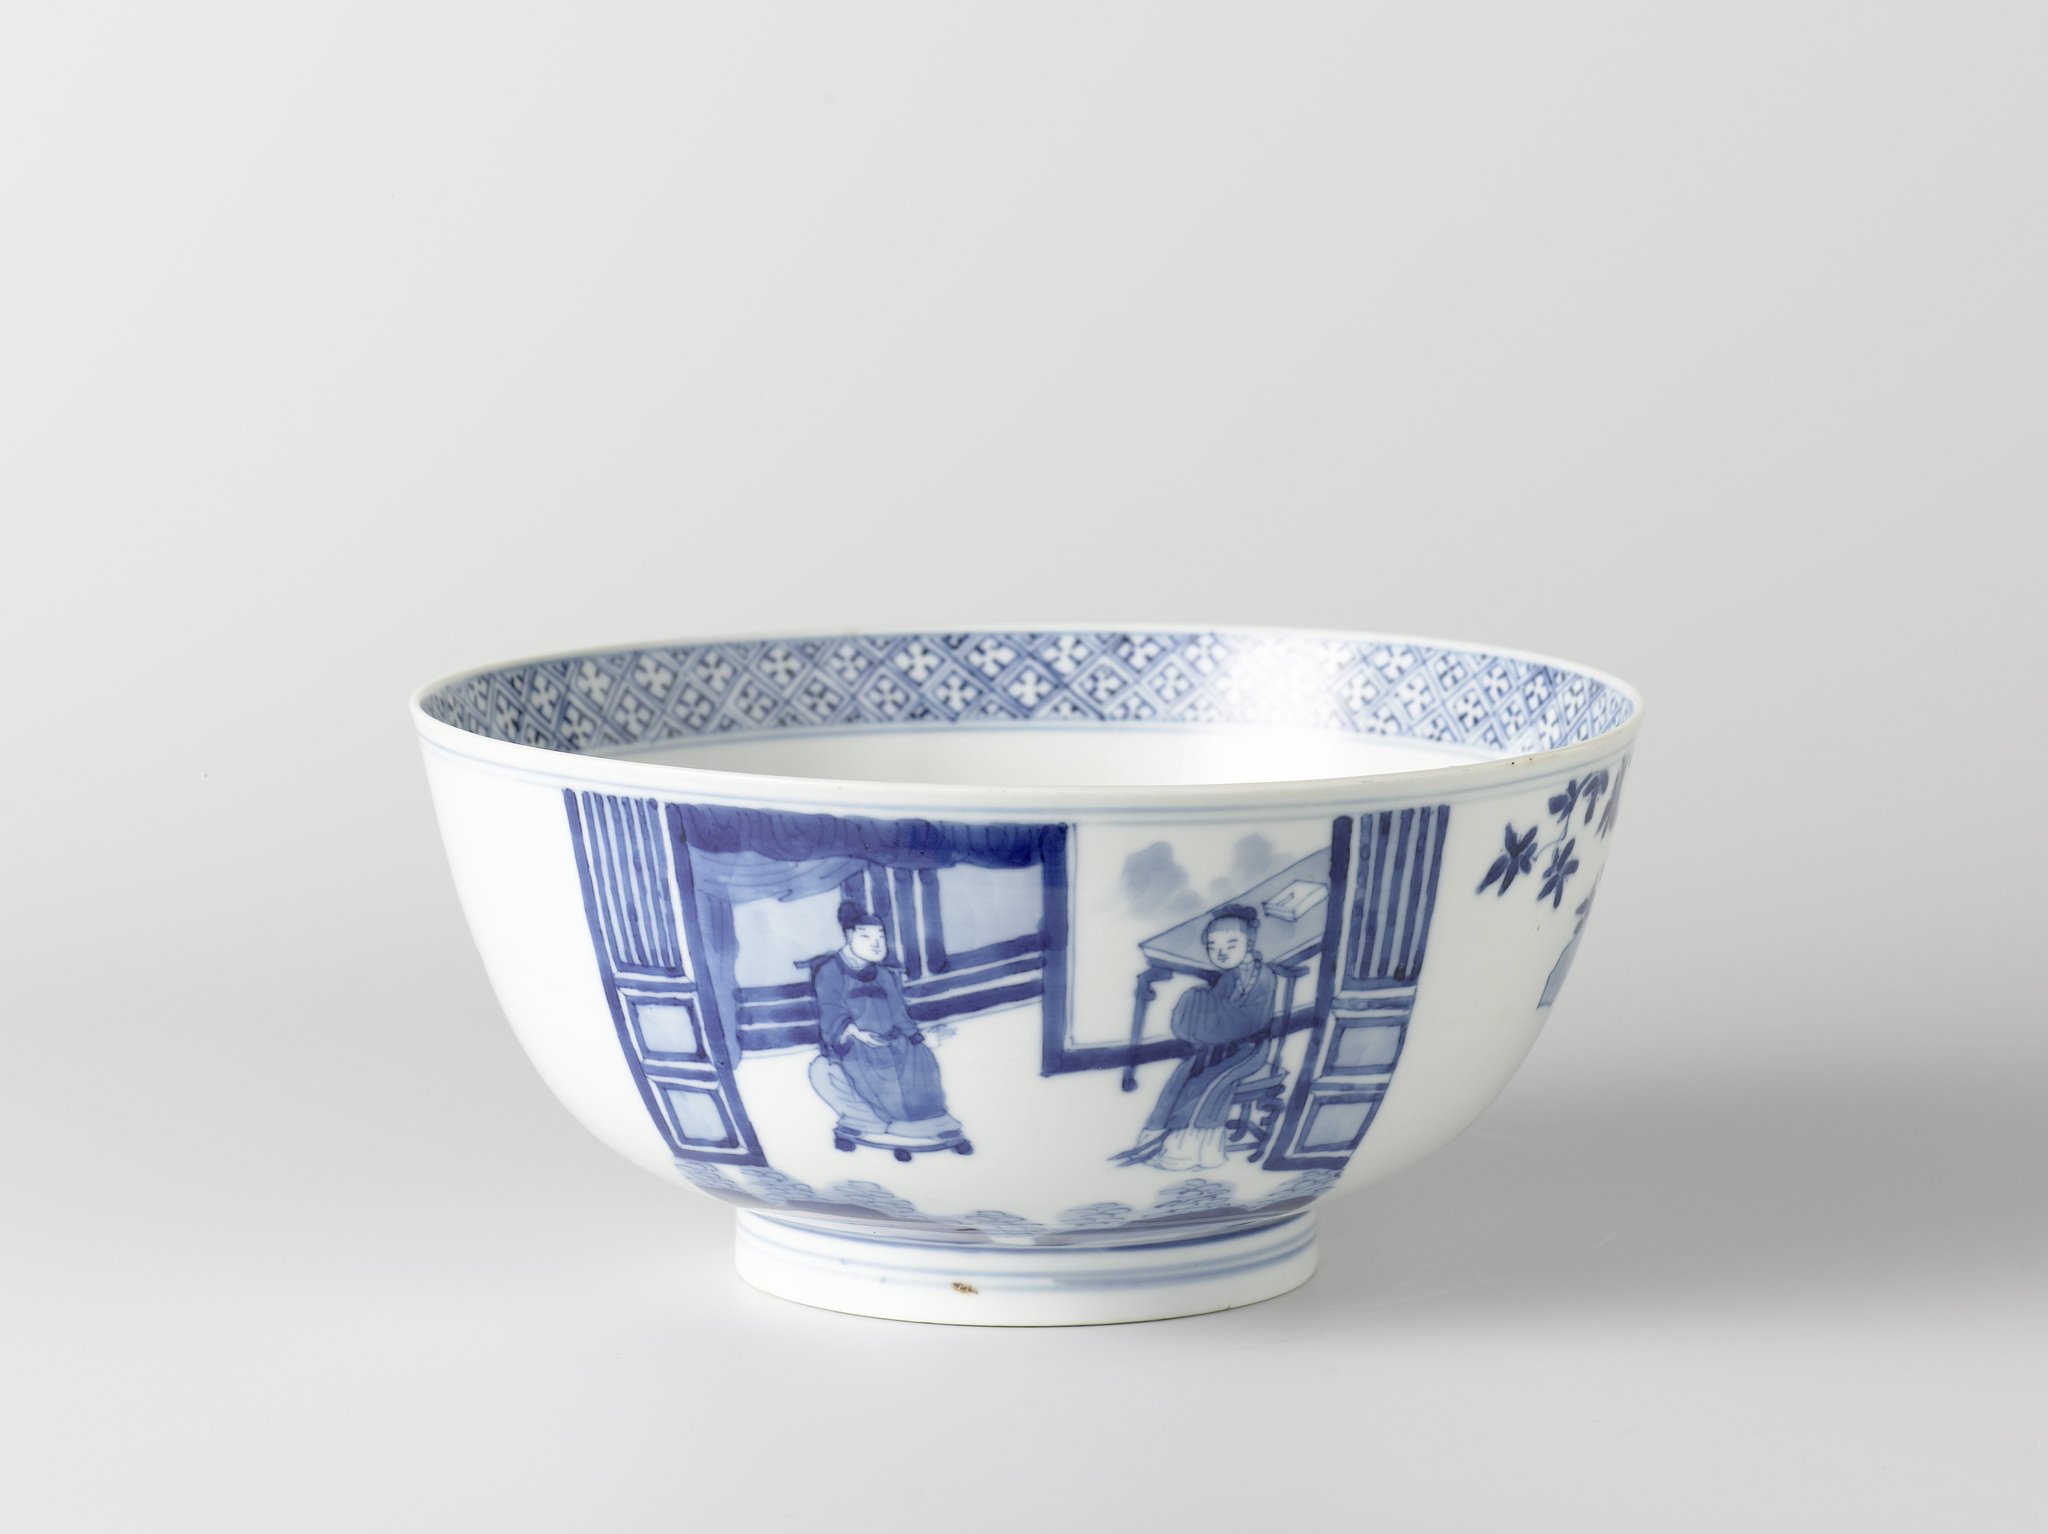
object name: bowl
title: Bowl with two narrative scenes and two trees near rocks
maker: Anonymous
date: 1680-1720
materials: cobalt, glaze, paint, porcelain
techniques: firing, turning, vitrification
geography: china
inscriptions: mark: ‘大 清 康 熙 年 製 dà qīng Kāng xī nián zhì’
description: Kom van porselein, beschilderd in onderglazuur blauw. Op de buintenzijde twee vakken met verhalende voorstellingen: drie personen in een interieur en twee zittende personen in een interieur, tussen de vakken een boom bij een rots; op de bodem drie spelende jongens (zotjes) in een landschap. Gemerkt op de onderzijde met het zes-karaktermerk van keizer Kangxi in een dubbele cirkel. Blauw-wit.